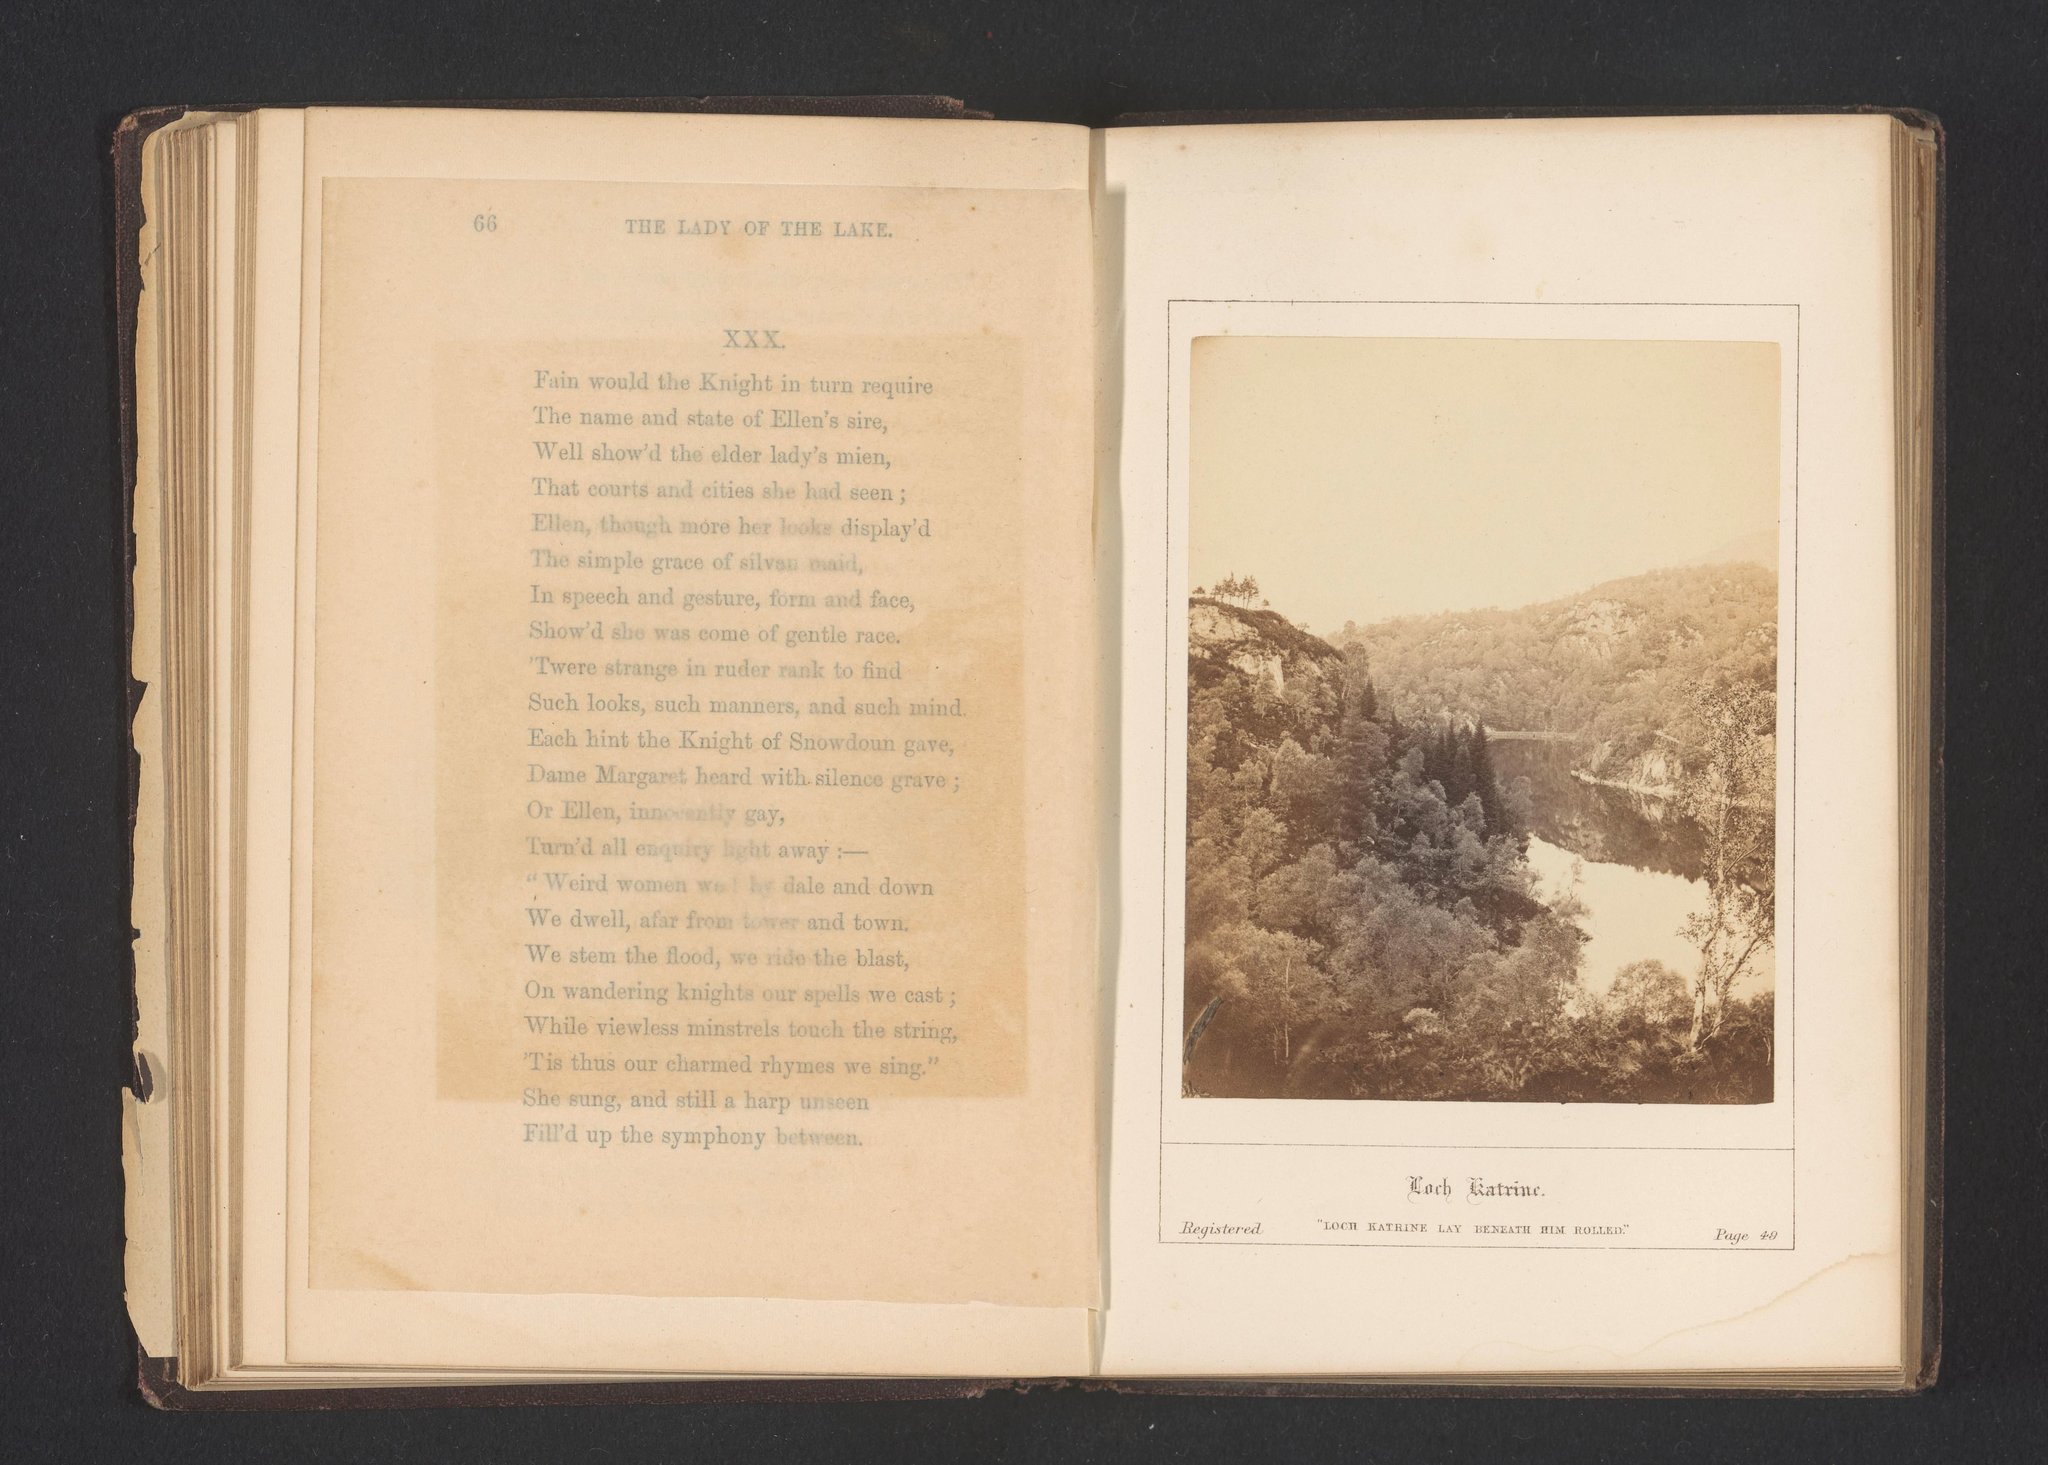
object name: photograph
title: Loch Katrine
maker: george washington wilson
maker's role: publisher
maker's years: 1823-1893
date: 1855-1865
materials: photographic support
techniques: albumen print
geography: loch katrine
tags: lake, forest, wood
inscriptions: inscription: ‘“Loch Katrine lay beneath him rolled”’, number: ‘Page 40.’